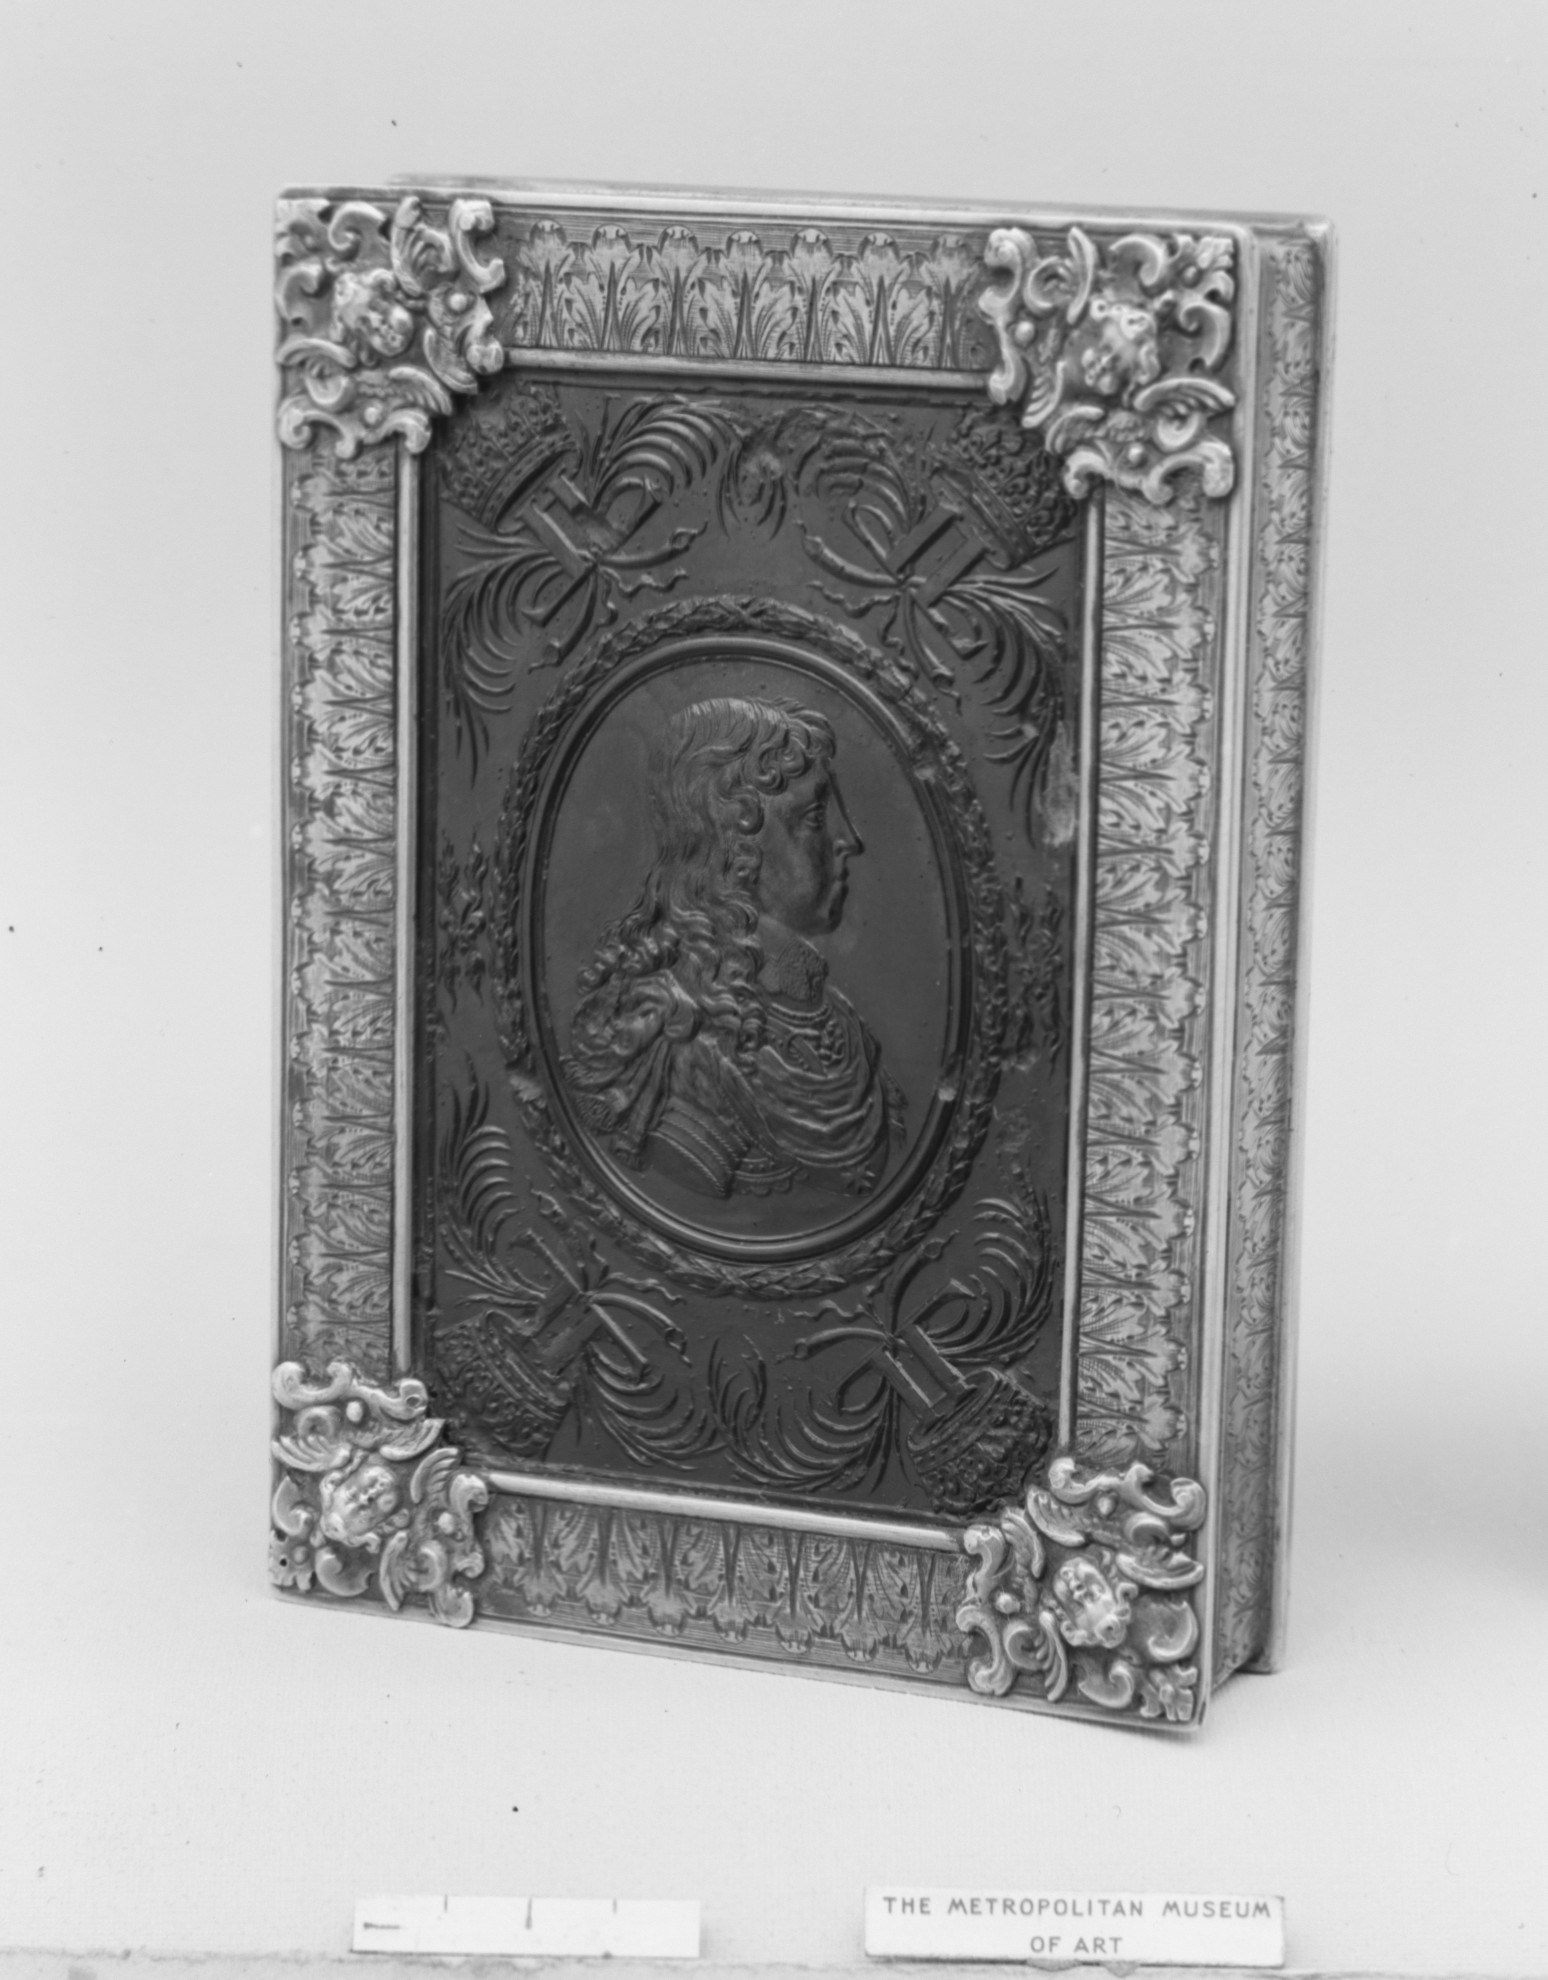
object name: box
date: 1601-1700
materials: silver, shell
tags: profiles